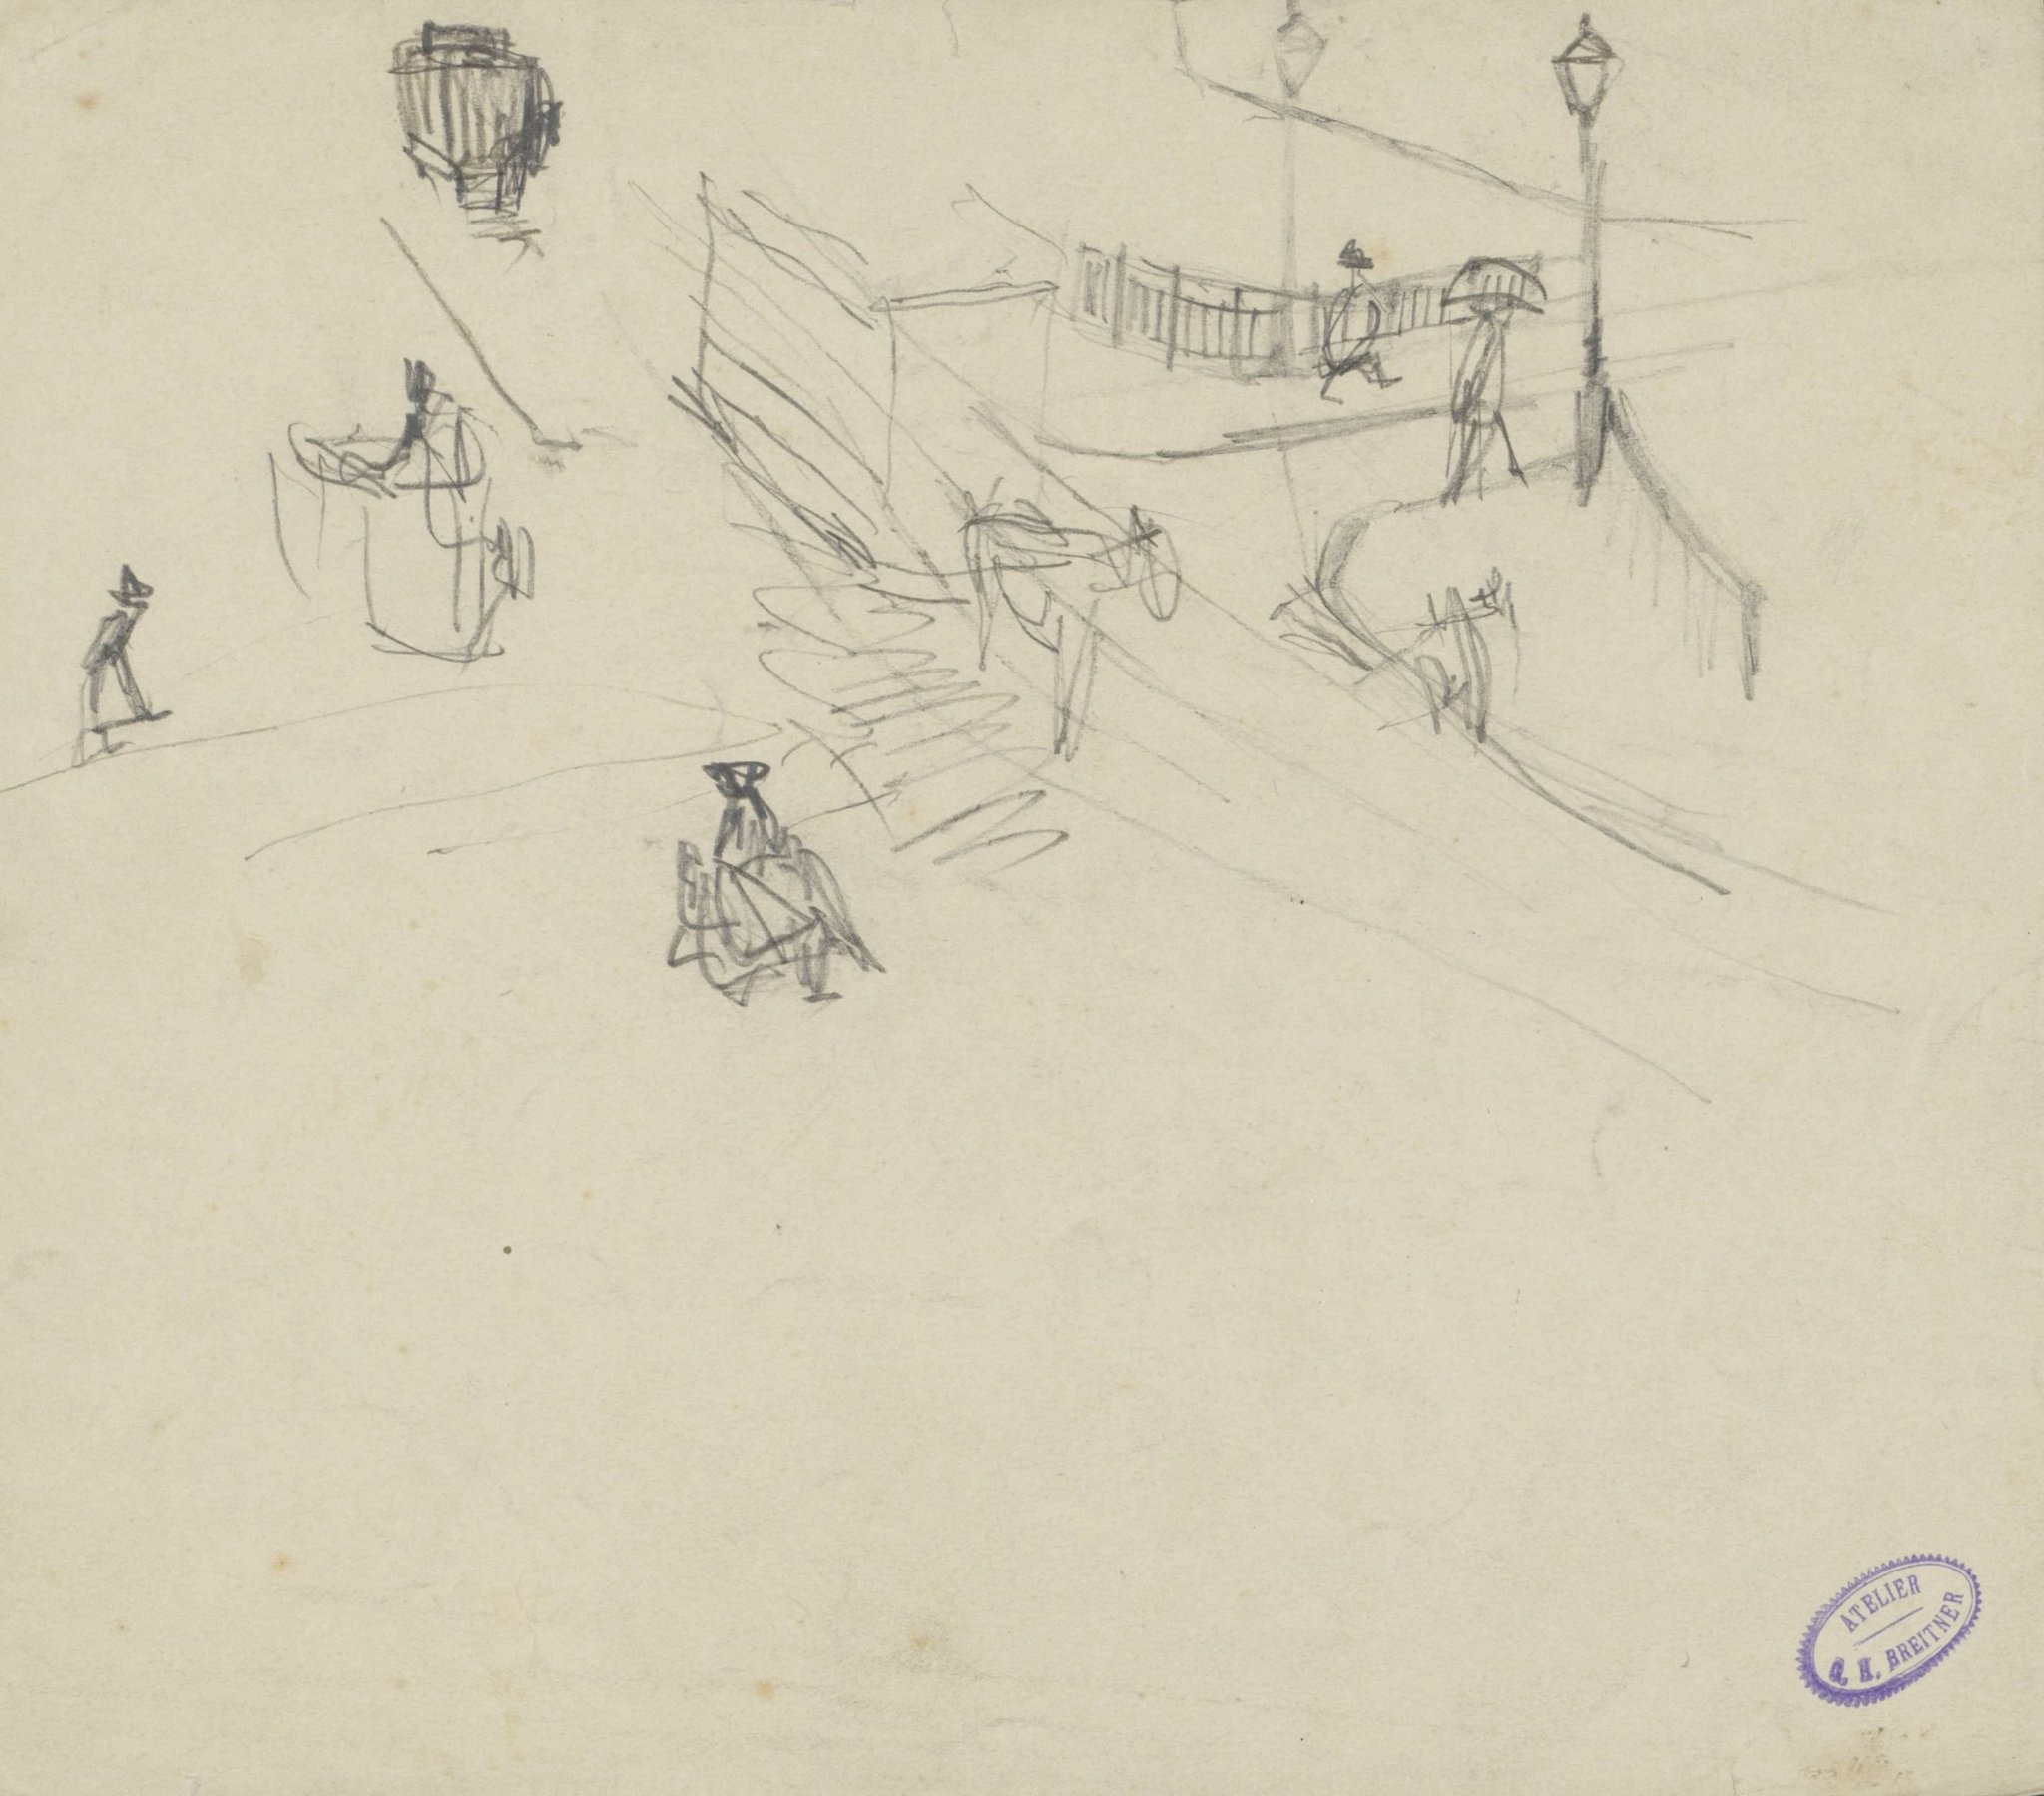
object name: drawing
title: Gezicht op het Rokin te Amsterdam, ter hoogte van het Spui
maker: george hendrik breitner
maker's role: draughtsman, painter, print maker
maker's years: 1857-1923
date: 1898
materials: paper, pencil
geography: amsterdam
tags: diligence, omnibus, horse-tram, canals, waters (in city) (+ city(-scape) with figures, staffage)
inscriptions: workshop stamp: Lugt 291d, collector's mark: Lugt 2228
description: Met de brug richting de Langebrugsteeg. Gezien vanuit kunstenaarsvereniging Arti et Amicitiae (Rokin 112).